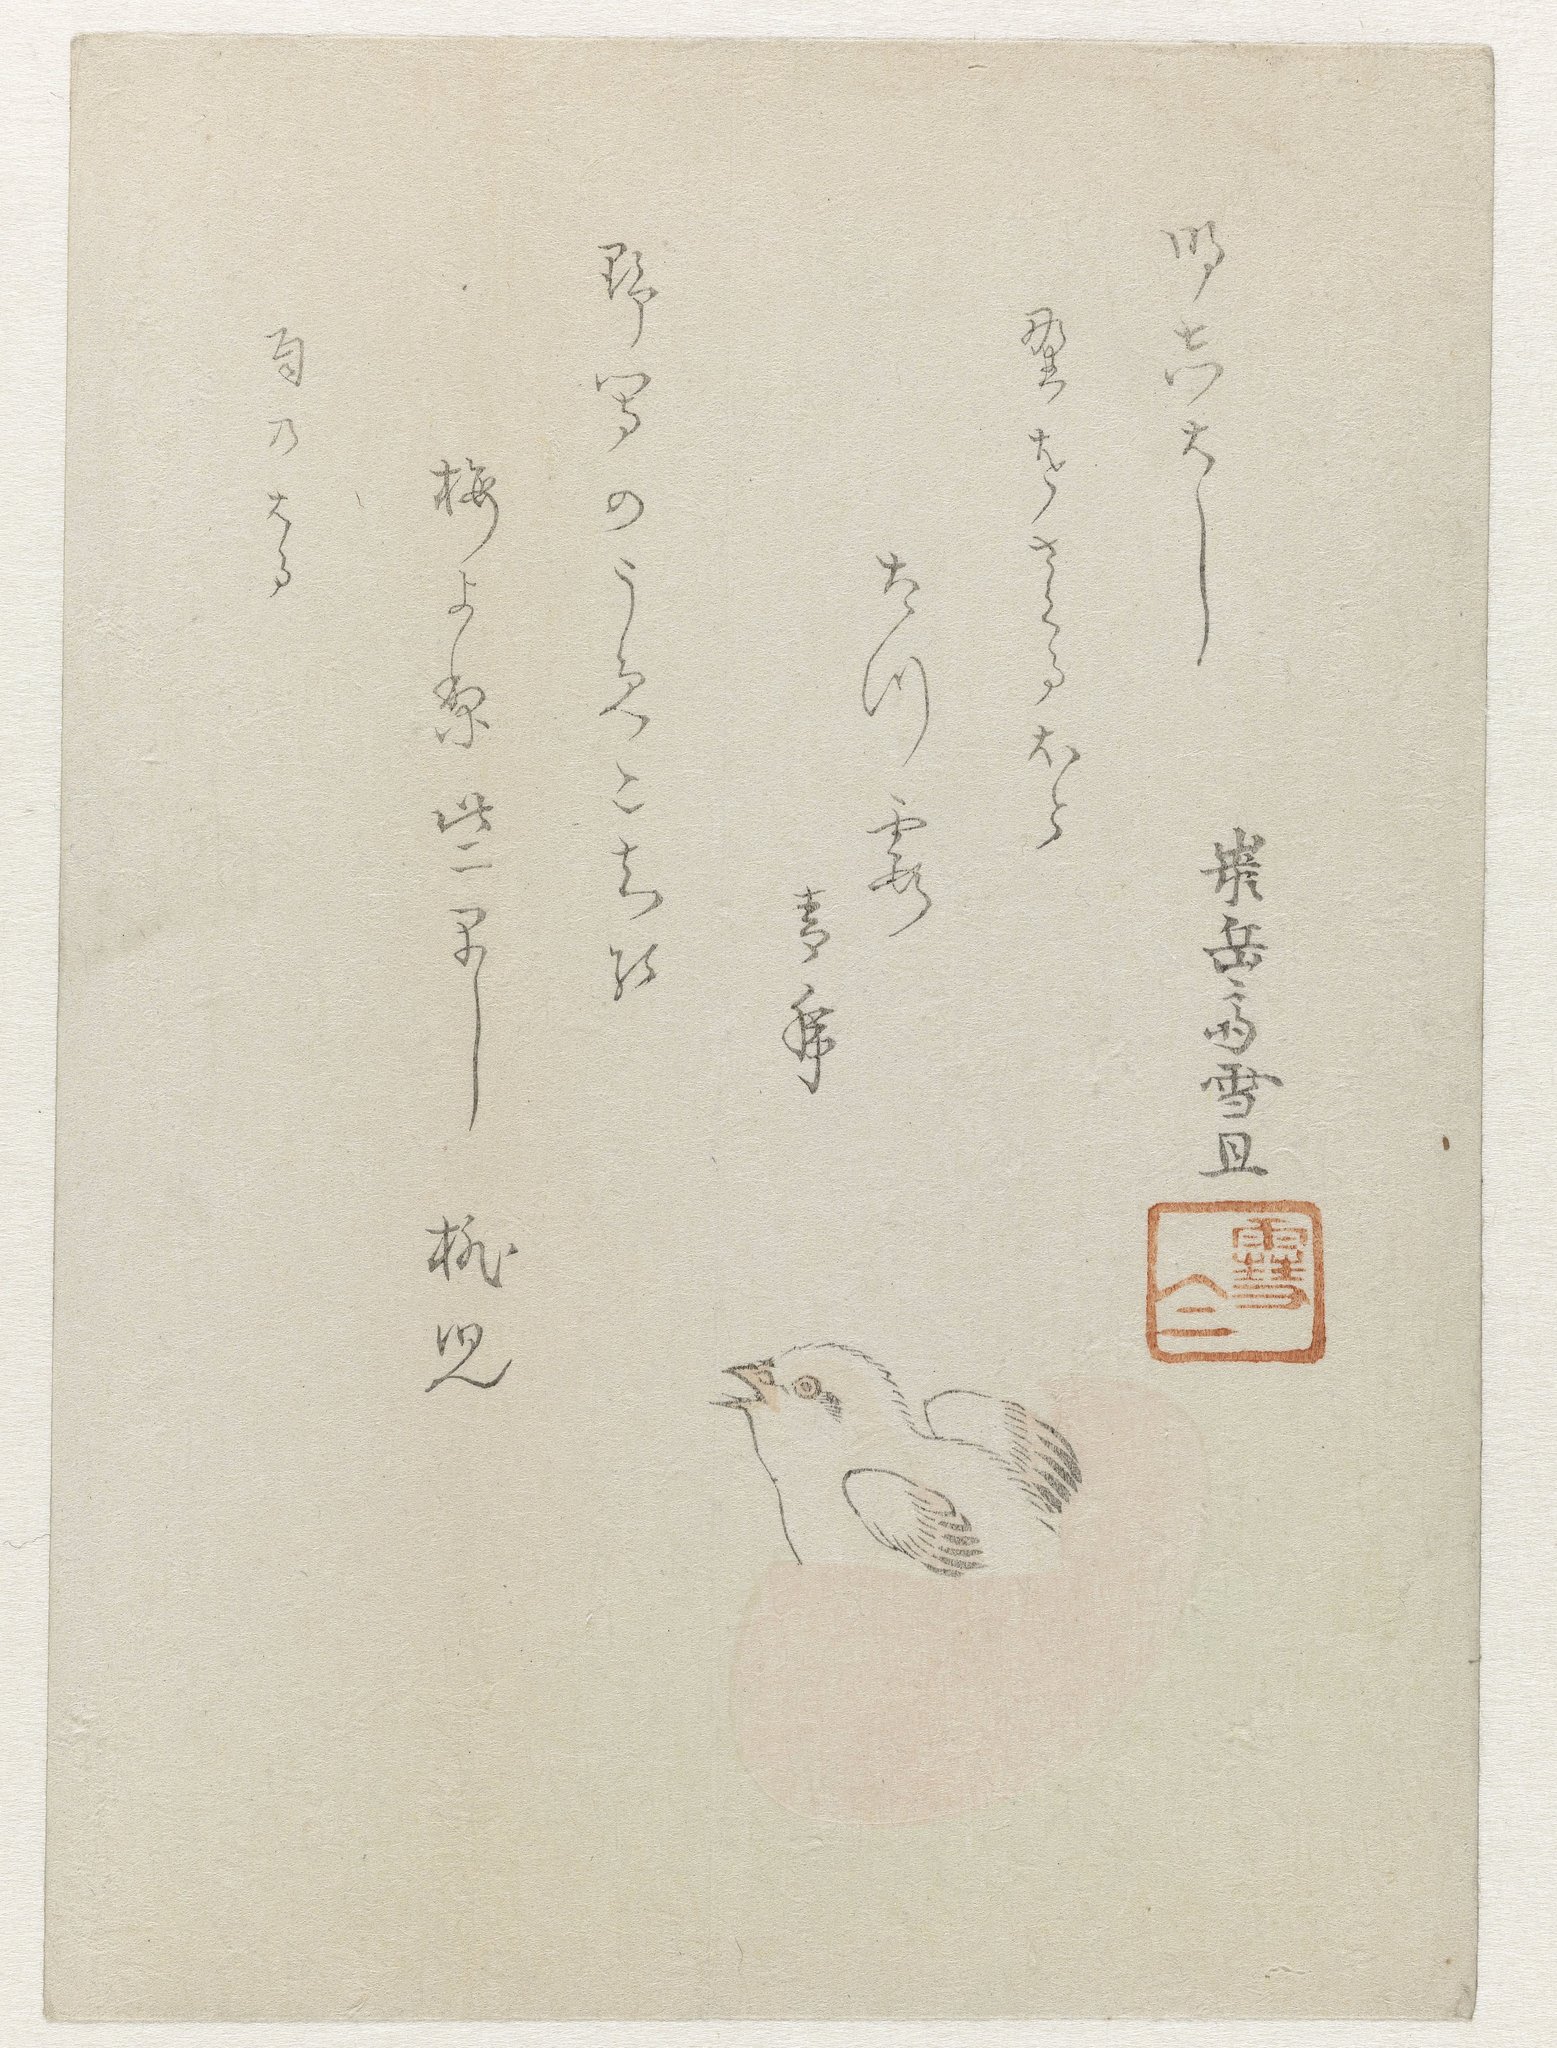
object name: print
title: Chick Hatching from an Egg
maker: hasegawa settan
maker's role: print maker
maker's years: 1778-1843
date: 1813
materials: paper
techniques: woodcut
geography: japan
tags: fowl (cock, hen, chicken, etc.)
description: Een surimono is een luxe uitgevoerde prent waarop beeld met één of meerdere gedichten gecombineerd is. Bij het drukken van een surimono werd vaak gebruik gemaakt van dikker papier, blinddruk en metaal pigmenten, zoals koper- en zilverpoeder. De prenten werden vaak in opdracht van dichters gemaakt en als exclusief geschenk aan vrienden en relaties gegeven.